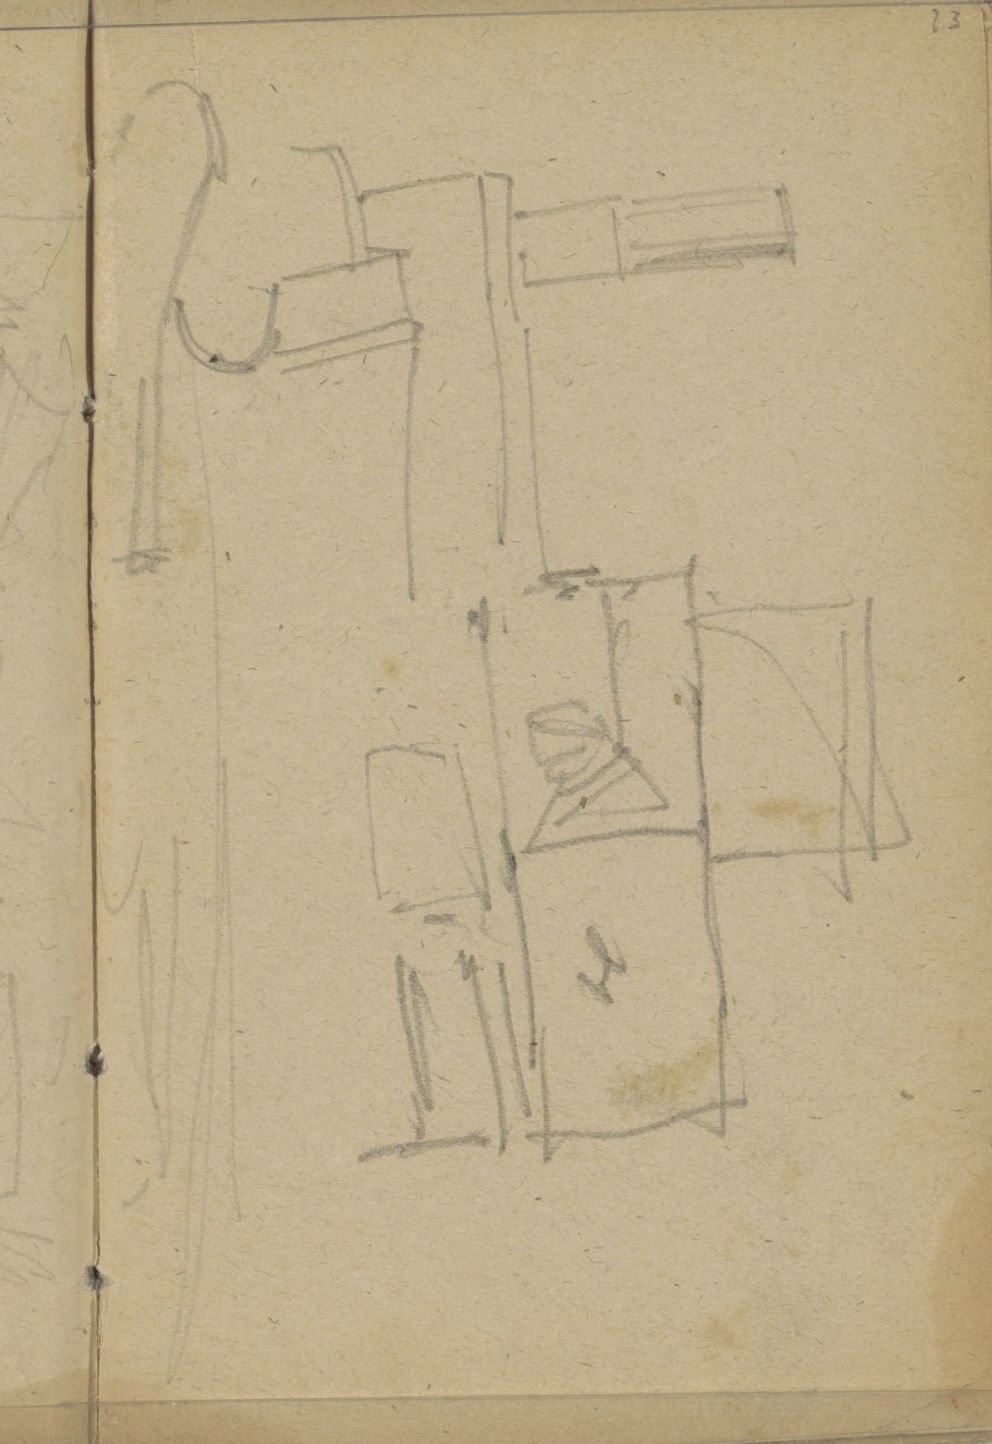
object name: sketchbook leaf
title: Studie, mogelijk van een boot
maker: george hendrik breitner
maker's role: draughtsman, painter, print maker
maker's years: 1857-1923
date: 1881-1883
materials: paper, pencil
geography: south holland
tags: ships (in general)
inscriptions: kleurnotitie, handgeschreven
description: Studie, mogelijk van een boot. Pagina 73 uit een schetsboek met 70 bladen.